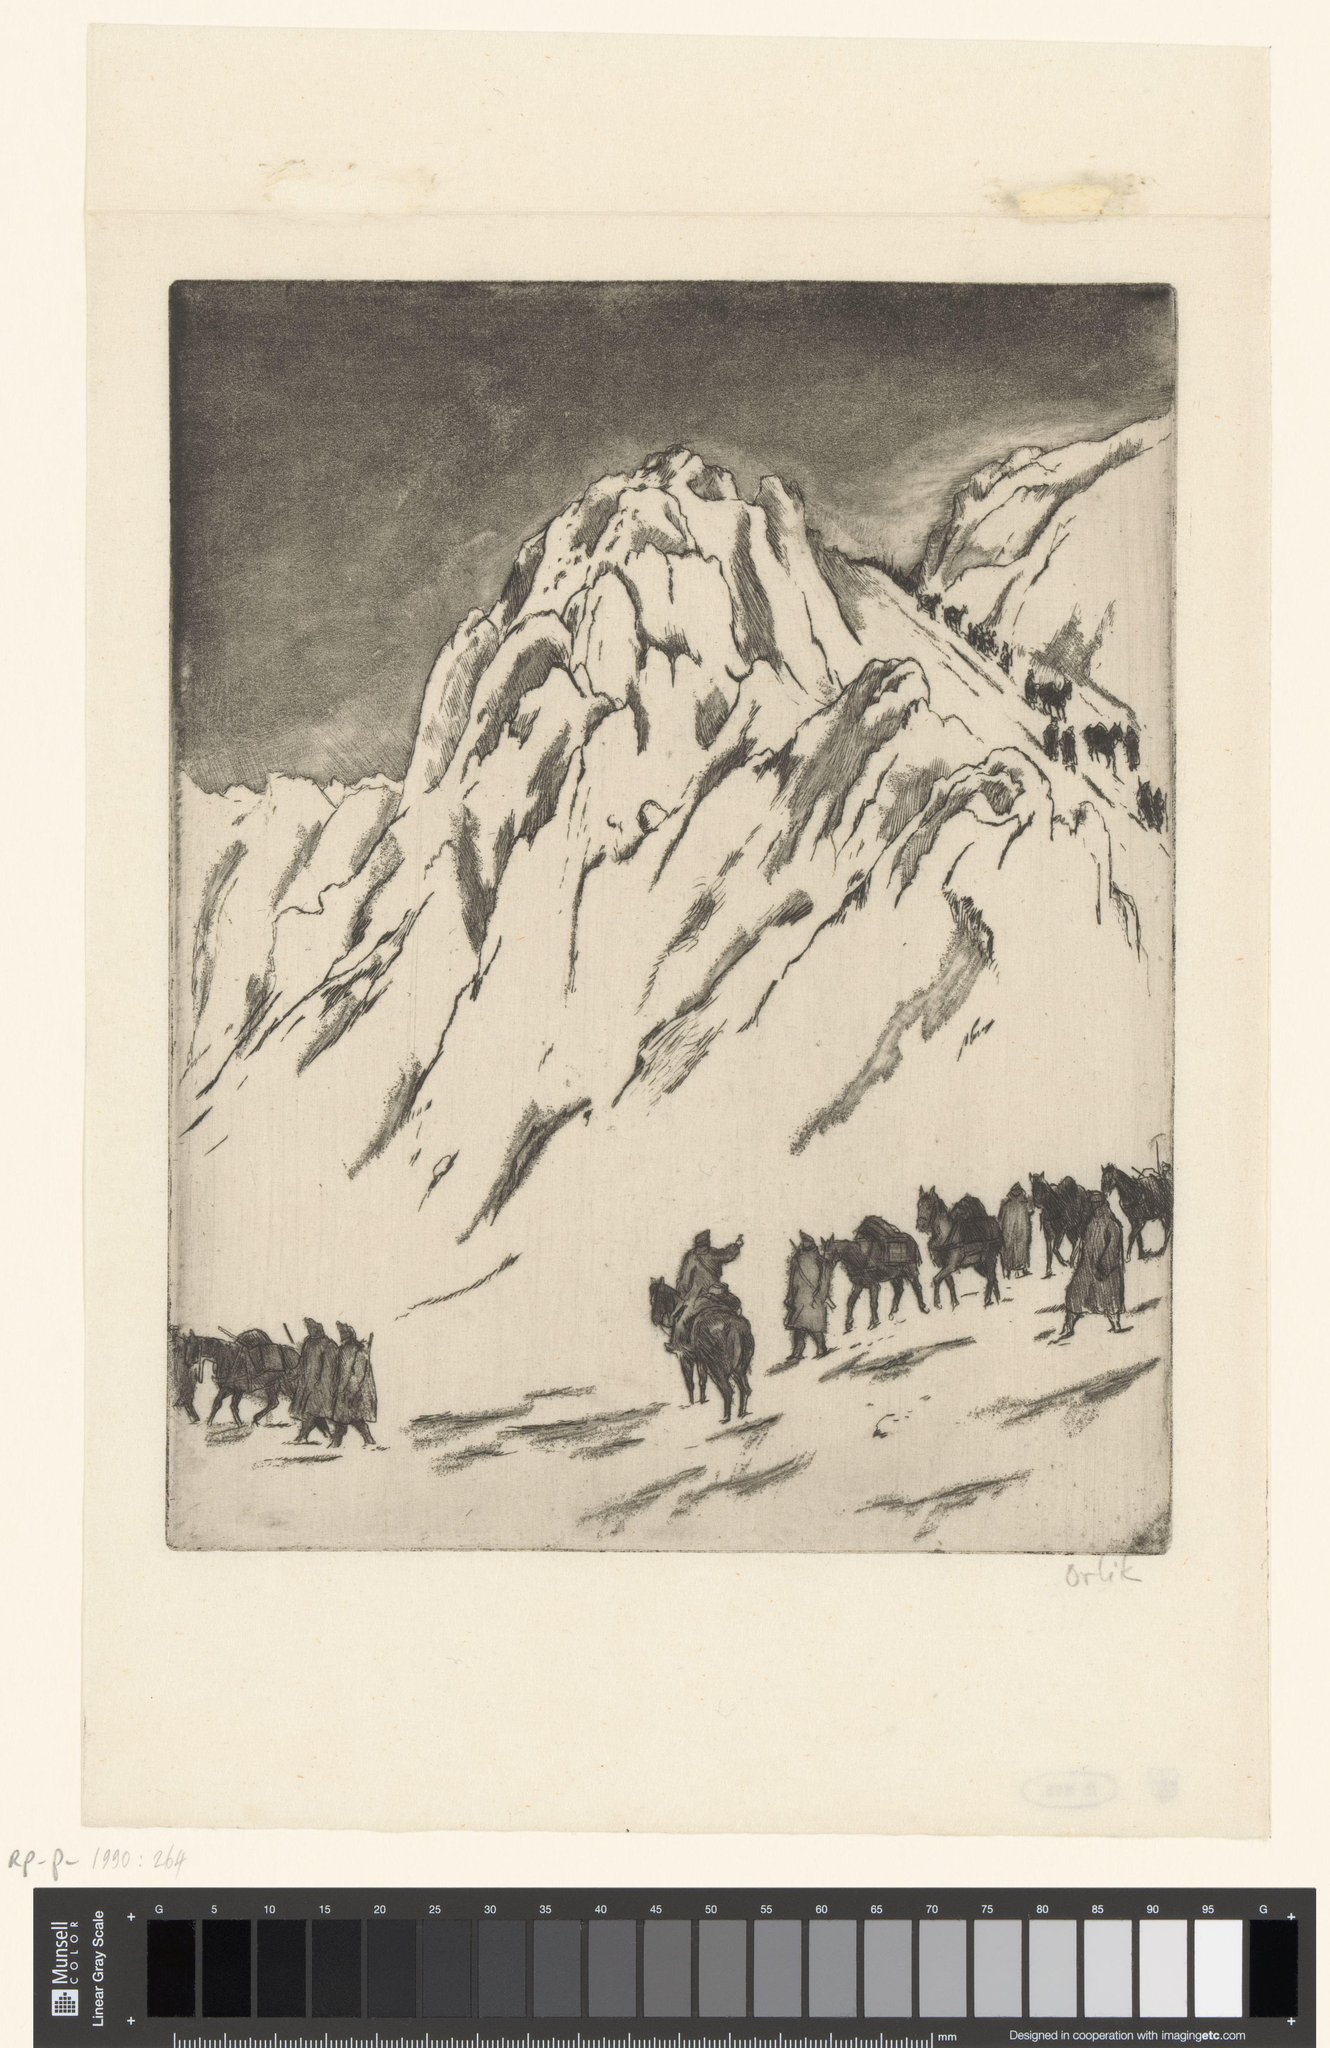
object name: print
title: Soldaten in sneeuwgebergte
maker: emil orlik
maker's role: painter, print maker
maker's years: 1870-1932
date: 1915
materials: paper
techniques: aquatint, etching, intaglio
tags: mountain climbing, mountaineering, the soldier; the soldier's life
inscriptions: name: ‘Orlik’, collector's mark: Lugt 2760, collector's mark: Lugt 2228